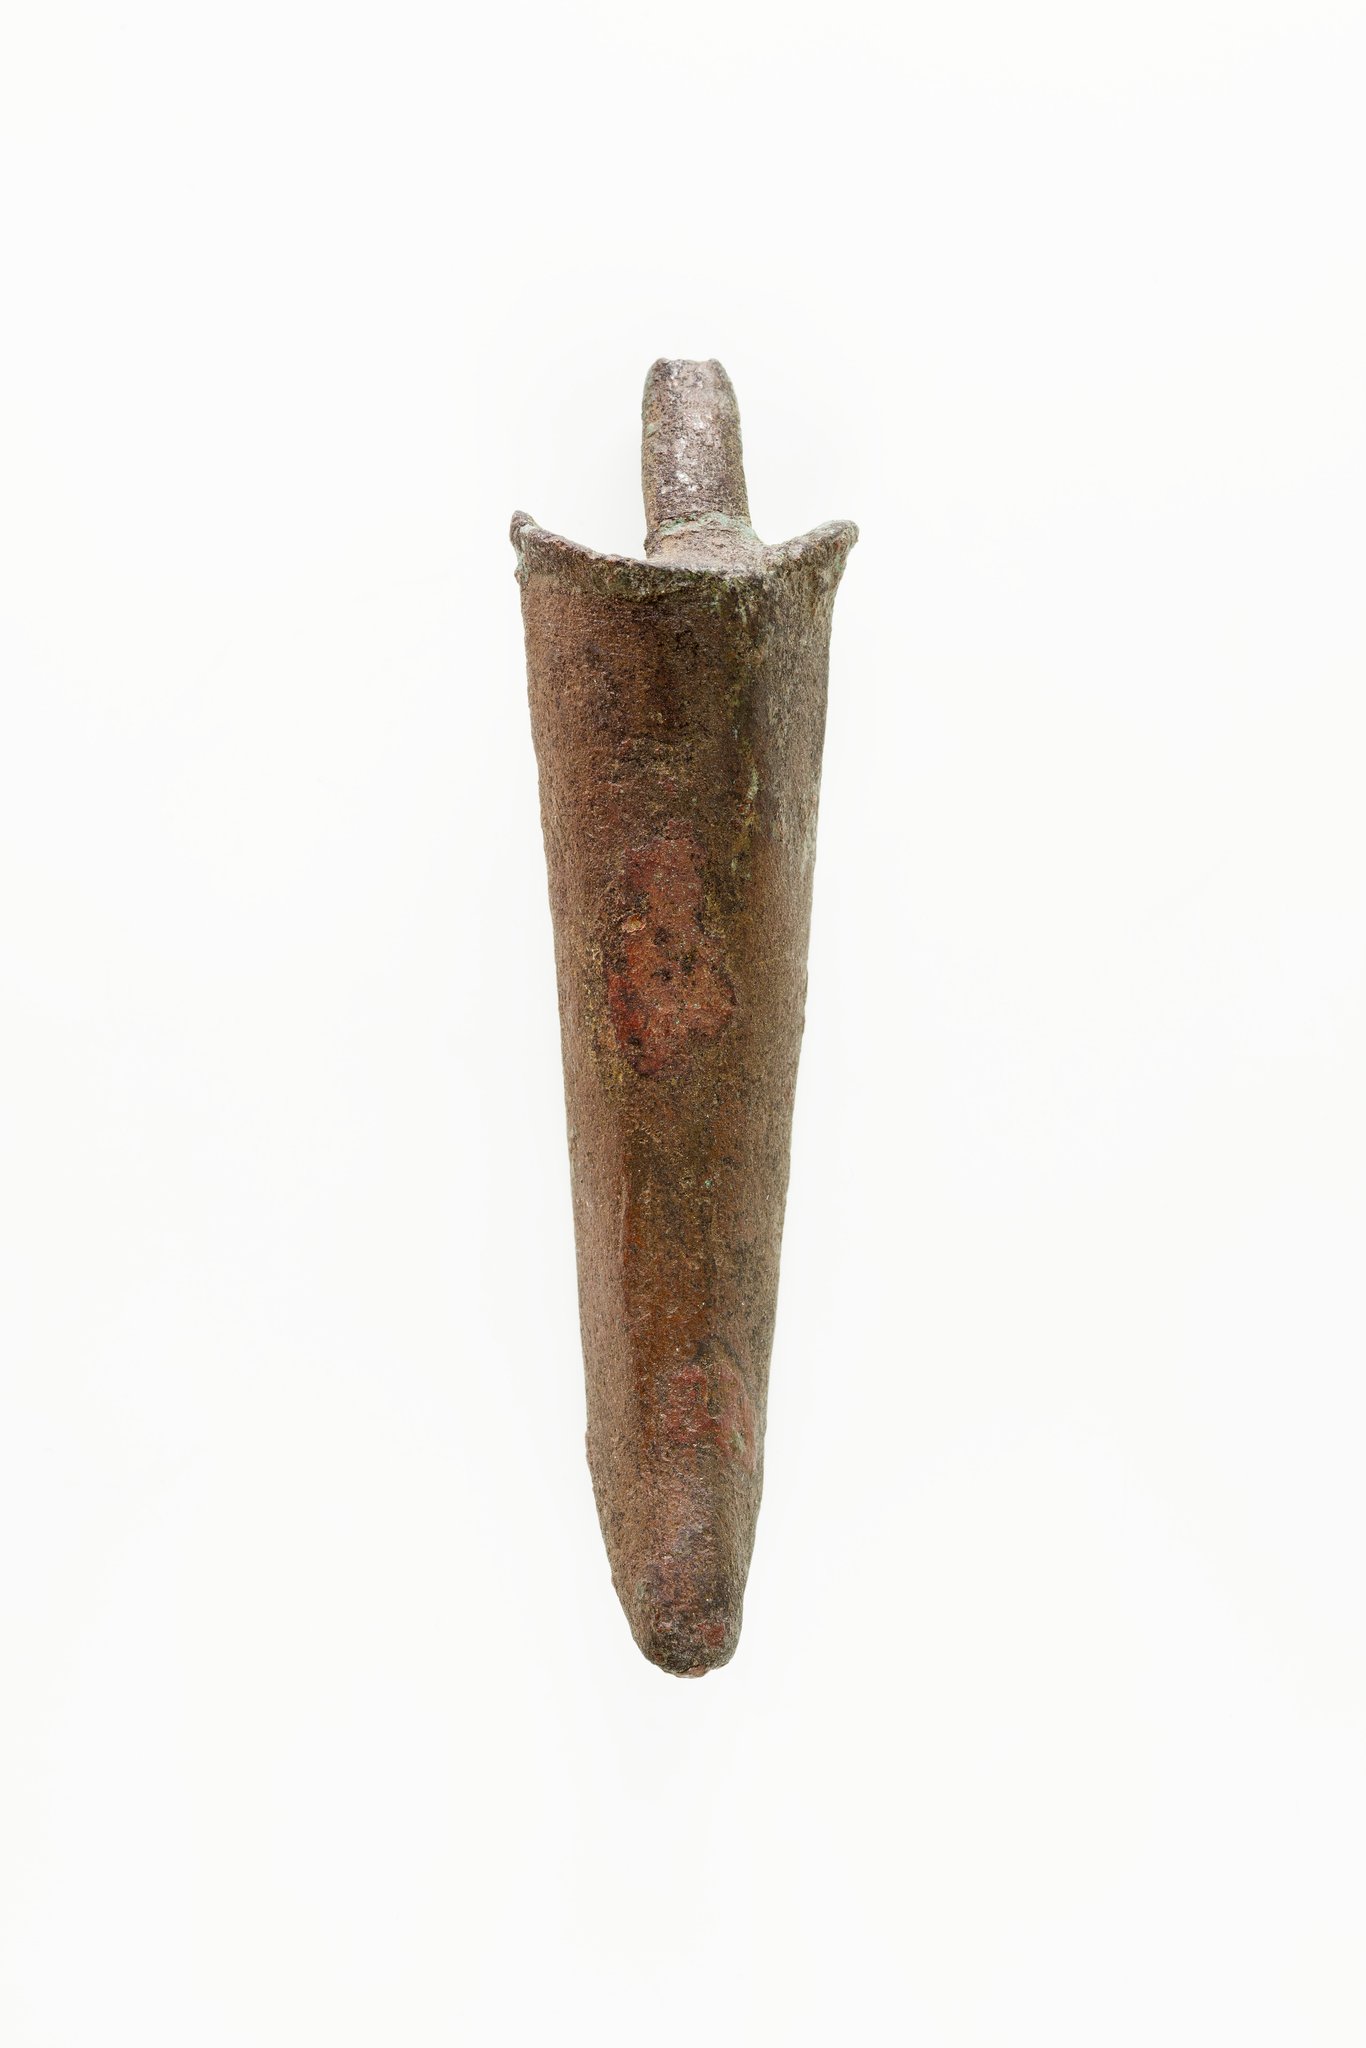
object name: statuette fragment, beard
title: Beard from a statuette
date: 712-30 BCE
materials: bronze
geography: egypt